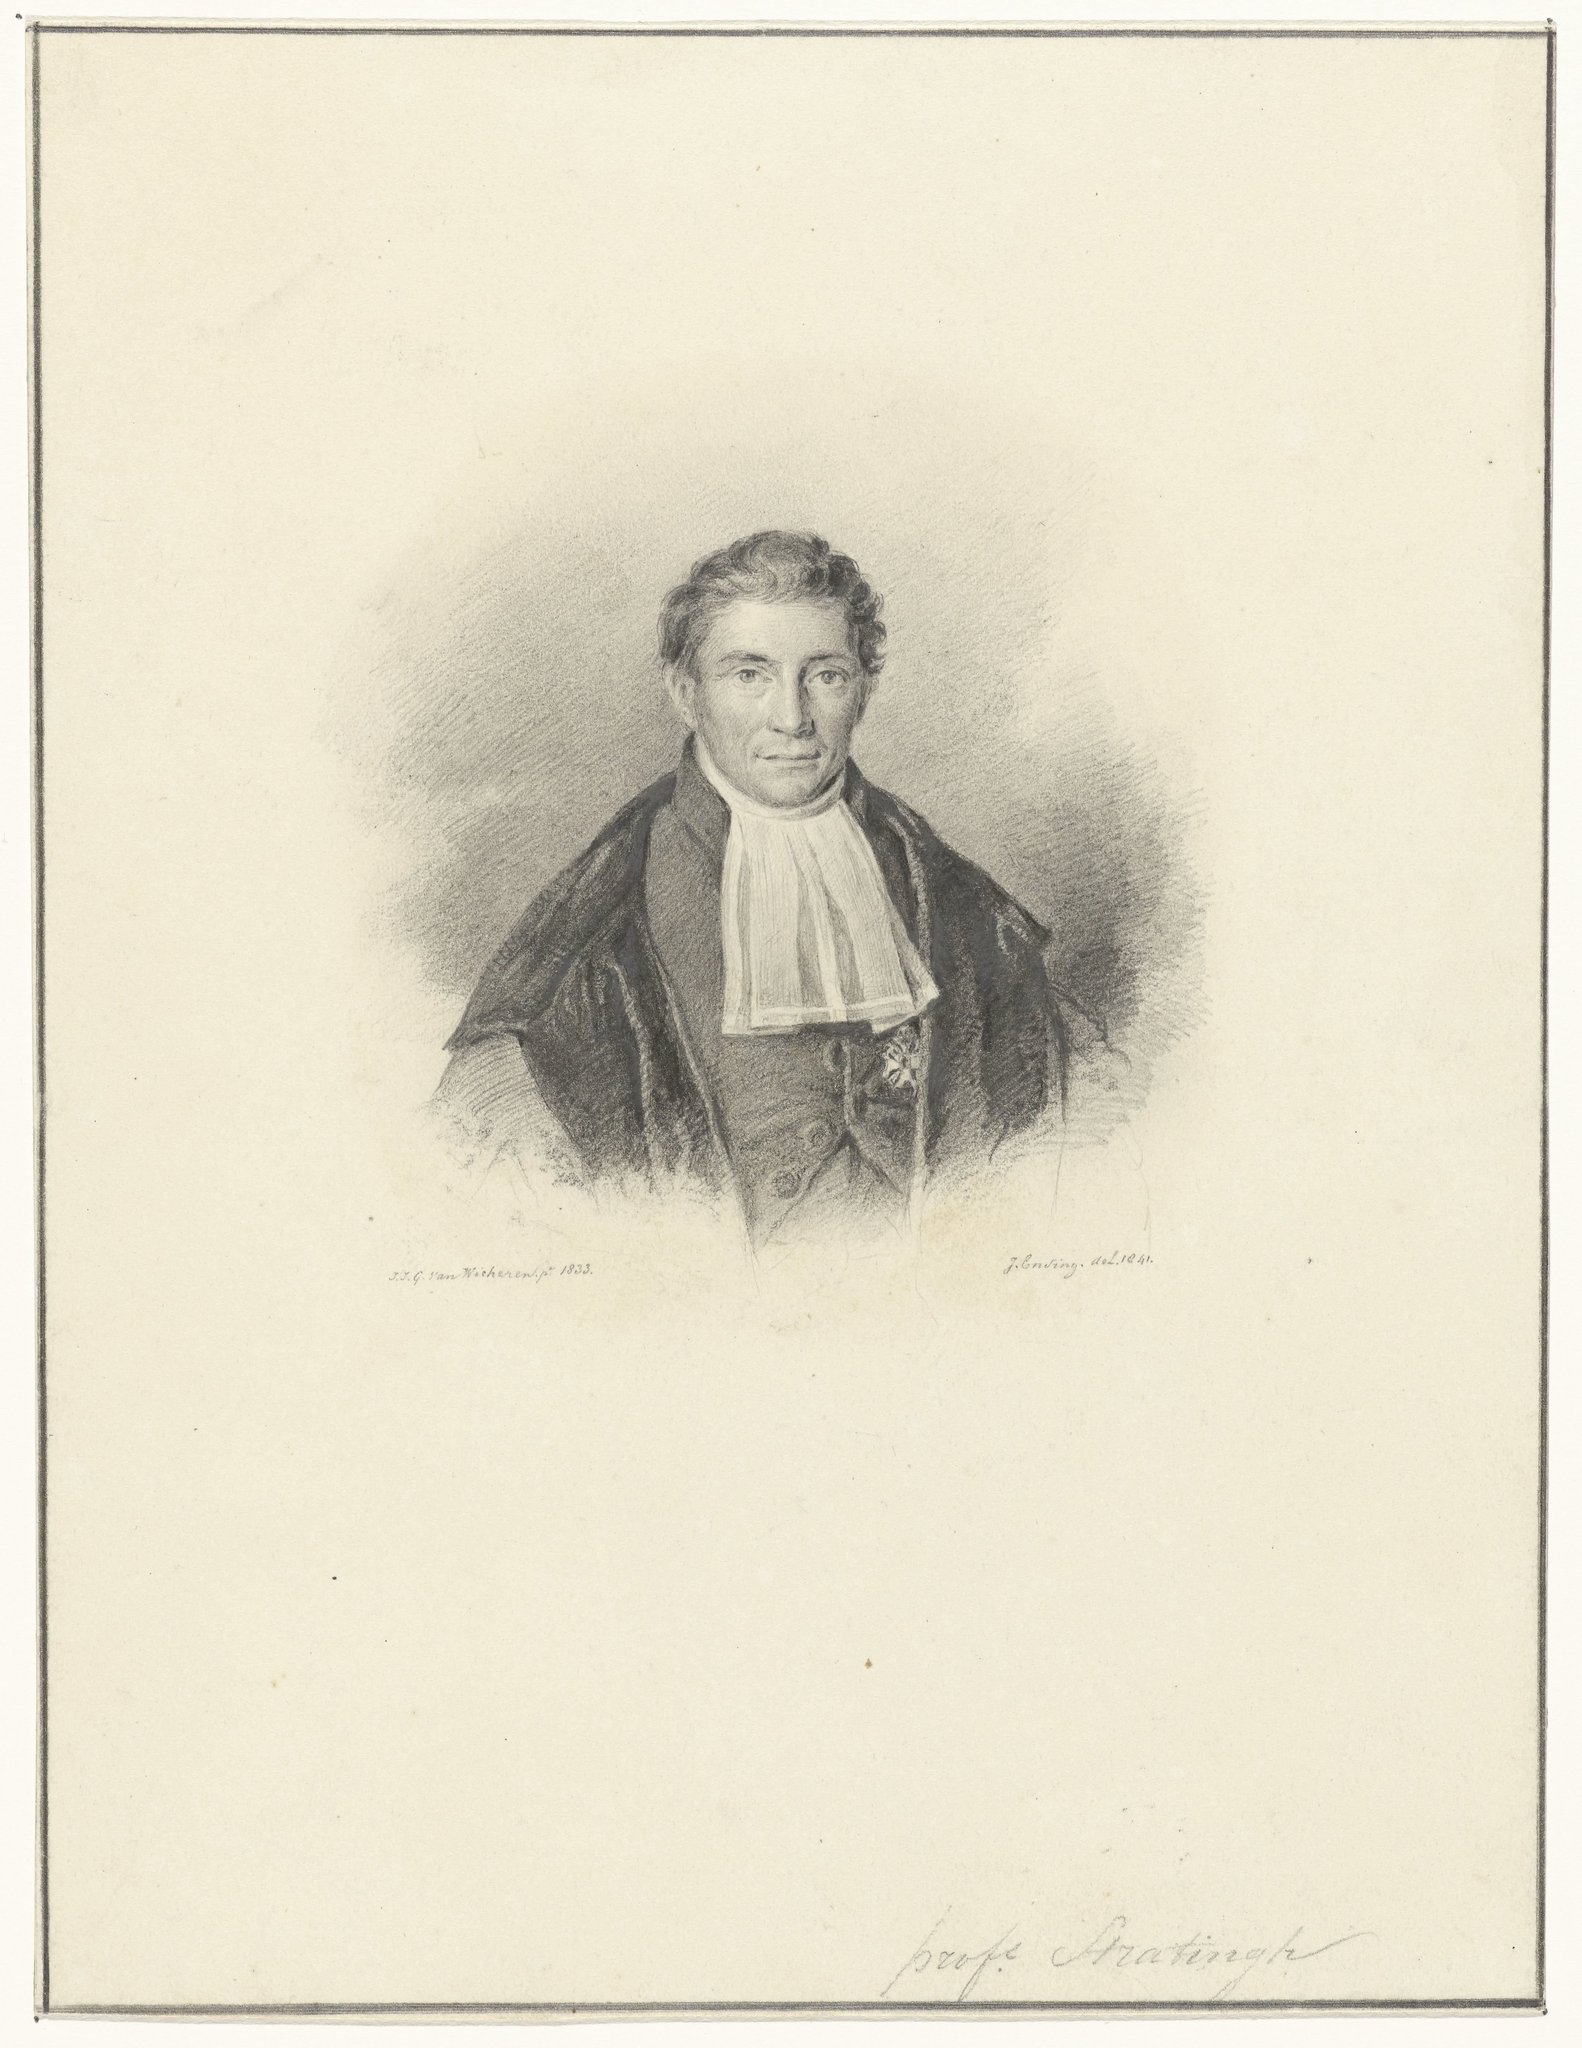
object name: drawing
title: Portret van Professor Sib. Stratingh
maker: jan ensing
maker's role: draughtsman, painter, print maker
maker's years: 1819-1894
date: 1841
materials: paper, pencil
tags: historical persons